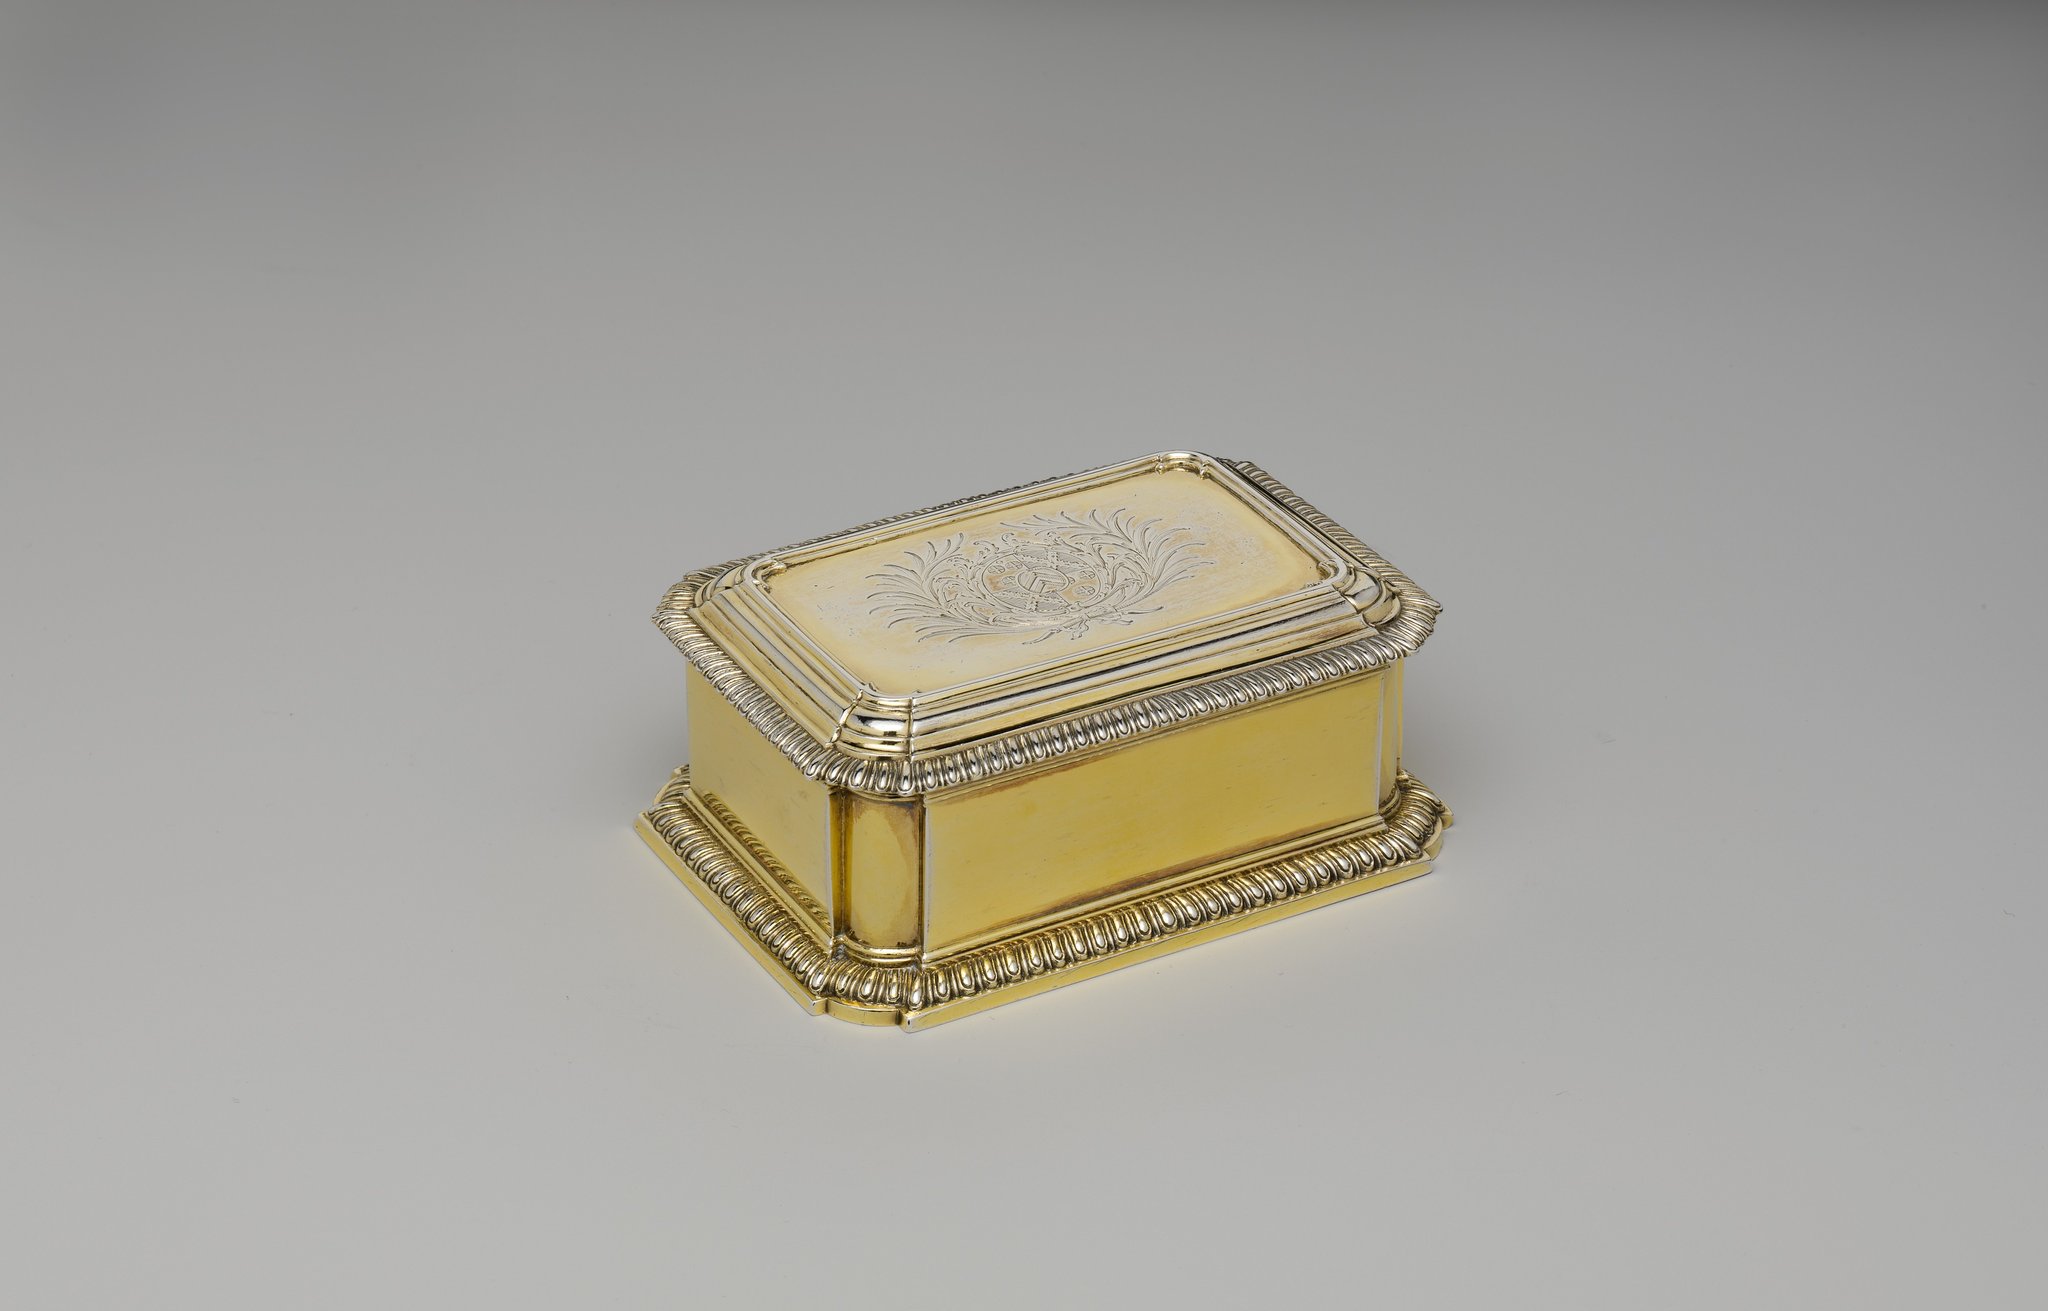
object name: toilet box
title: Toilet box (one of a pair) (part of a set)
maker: john parker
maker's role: maker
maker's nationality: british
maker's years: 1759-1777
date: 1766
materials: silver gilt